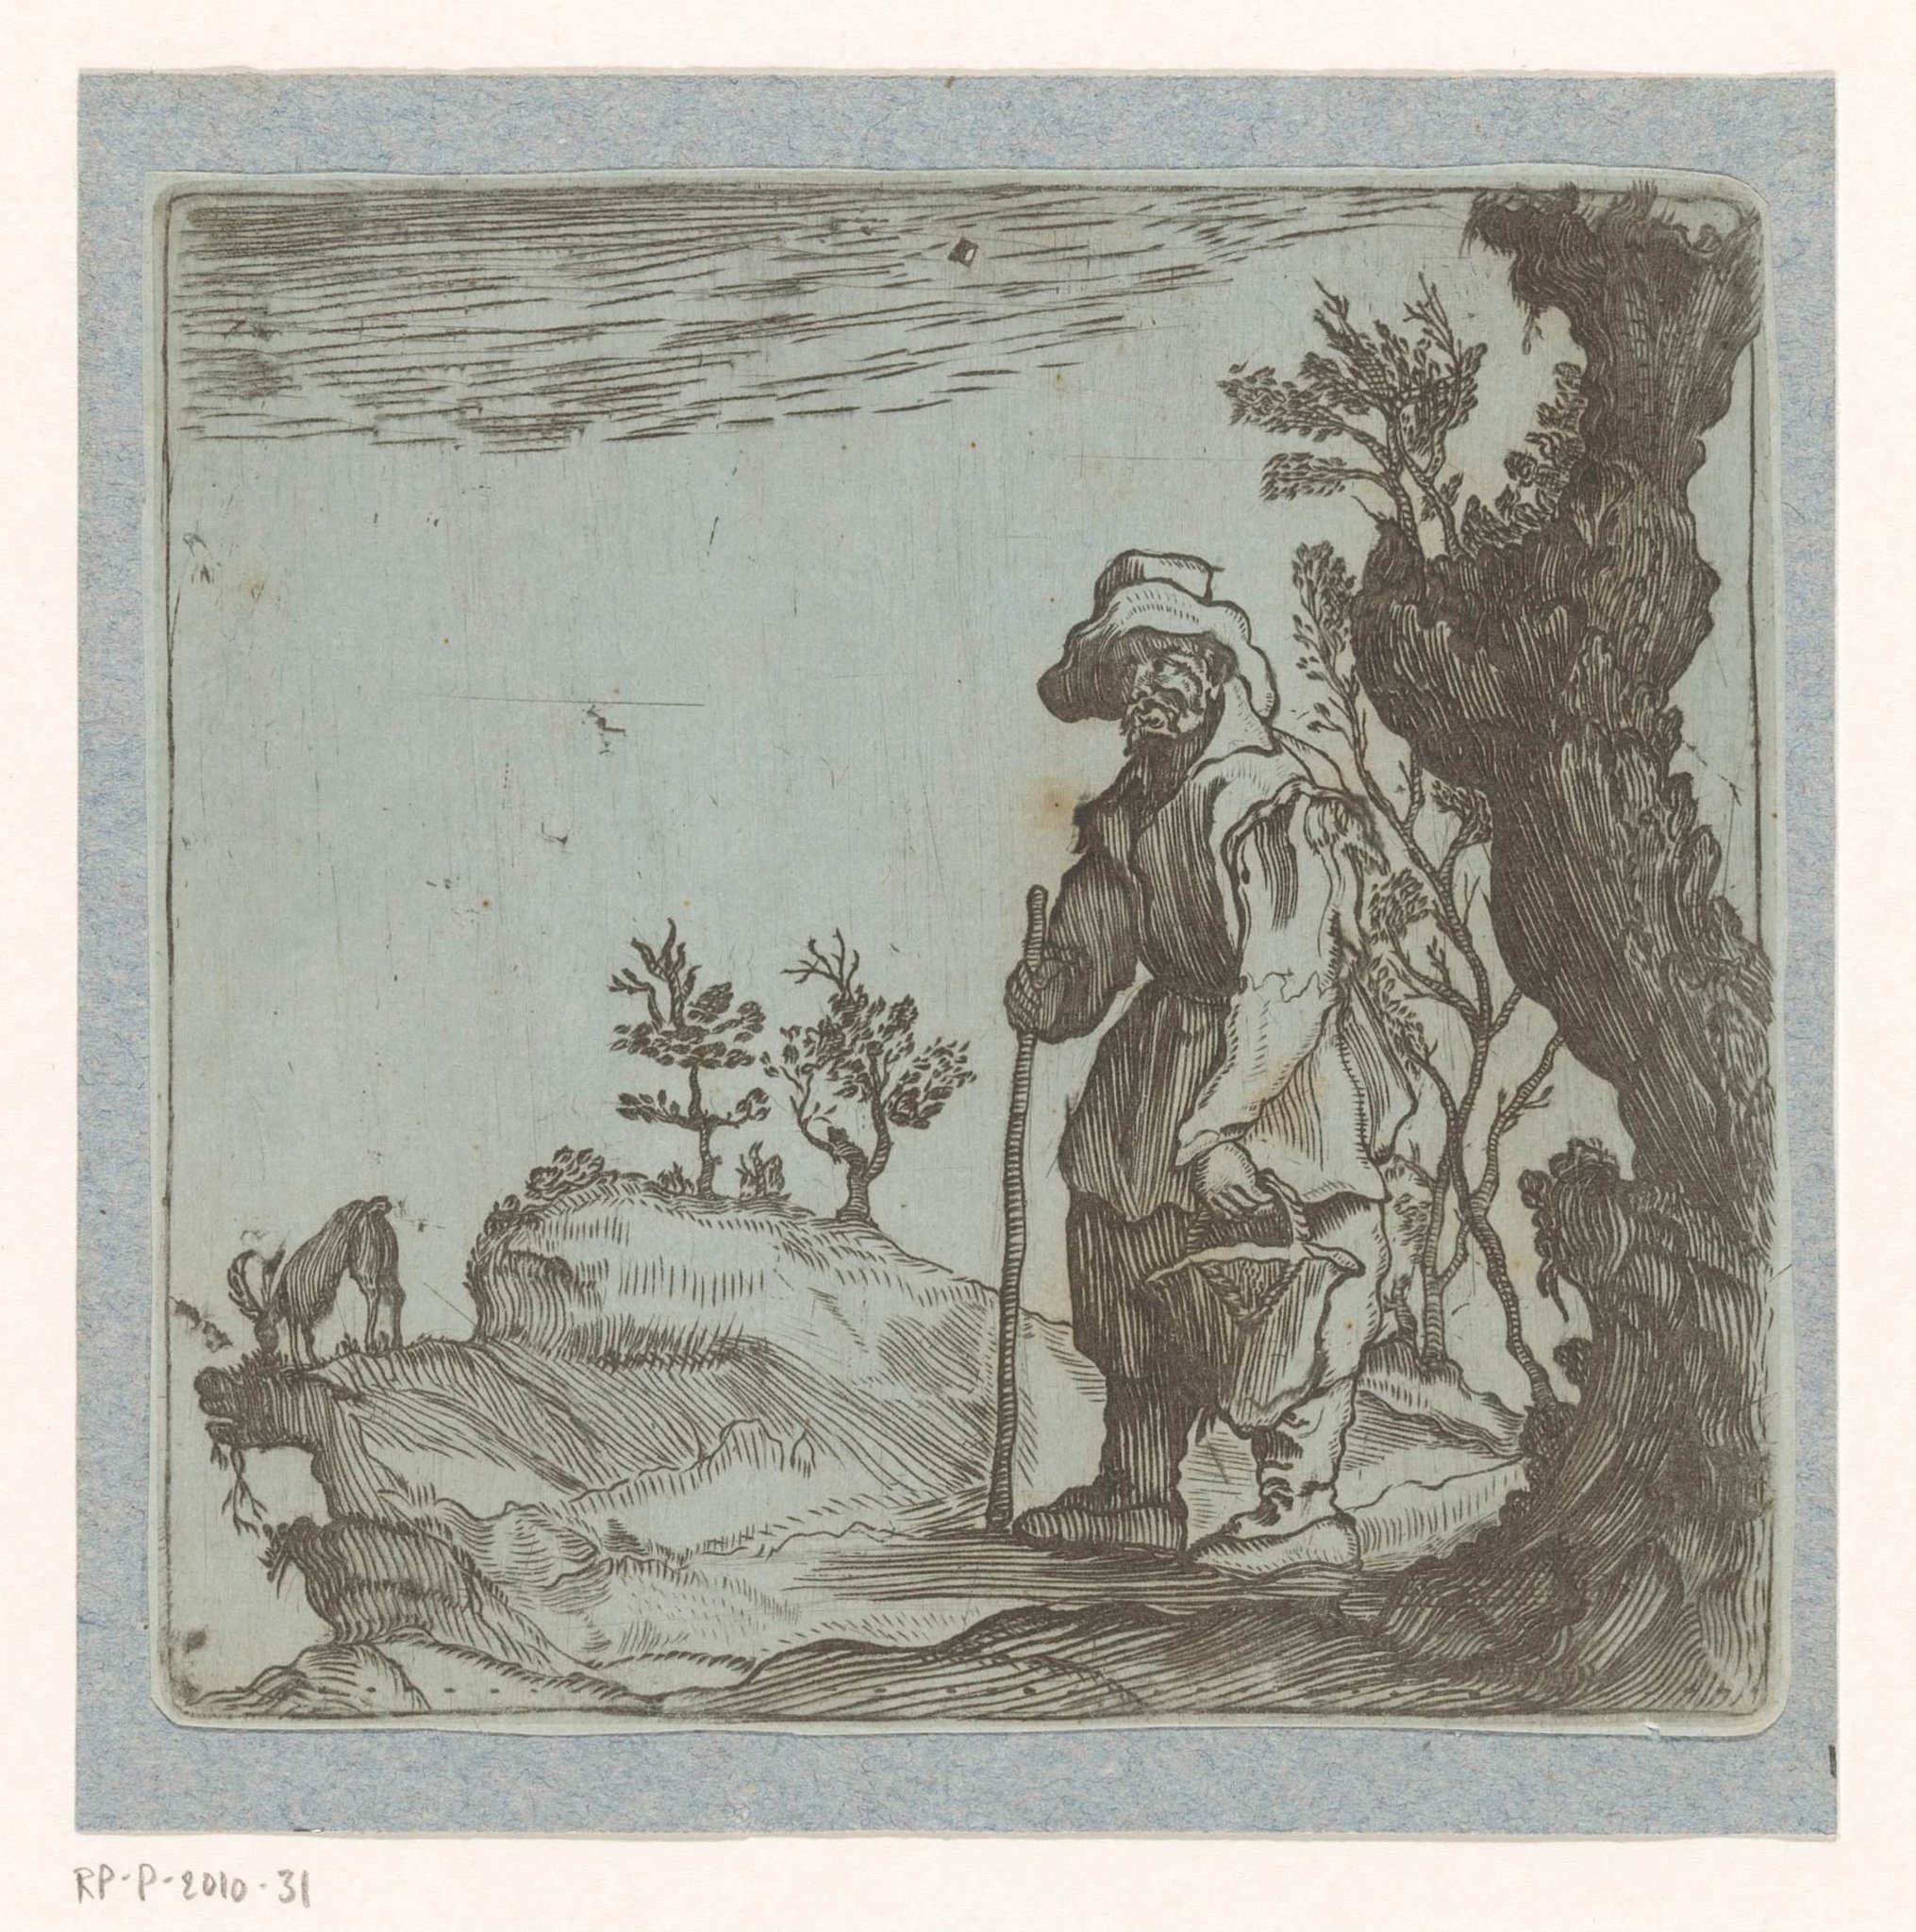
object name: print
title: Boer met mand in een landschap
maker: Anonymous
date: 1640-1700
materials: paper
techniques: etching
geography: tuscany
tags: landscapes, farmers, inland cliff face, goat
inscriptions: collector's mark: Lugt 2228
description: Naast een boomstronk staat een boer met in de ene hand een mand en in de andere hand een stok. Links een grazende geit op een klip.